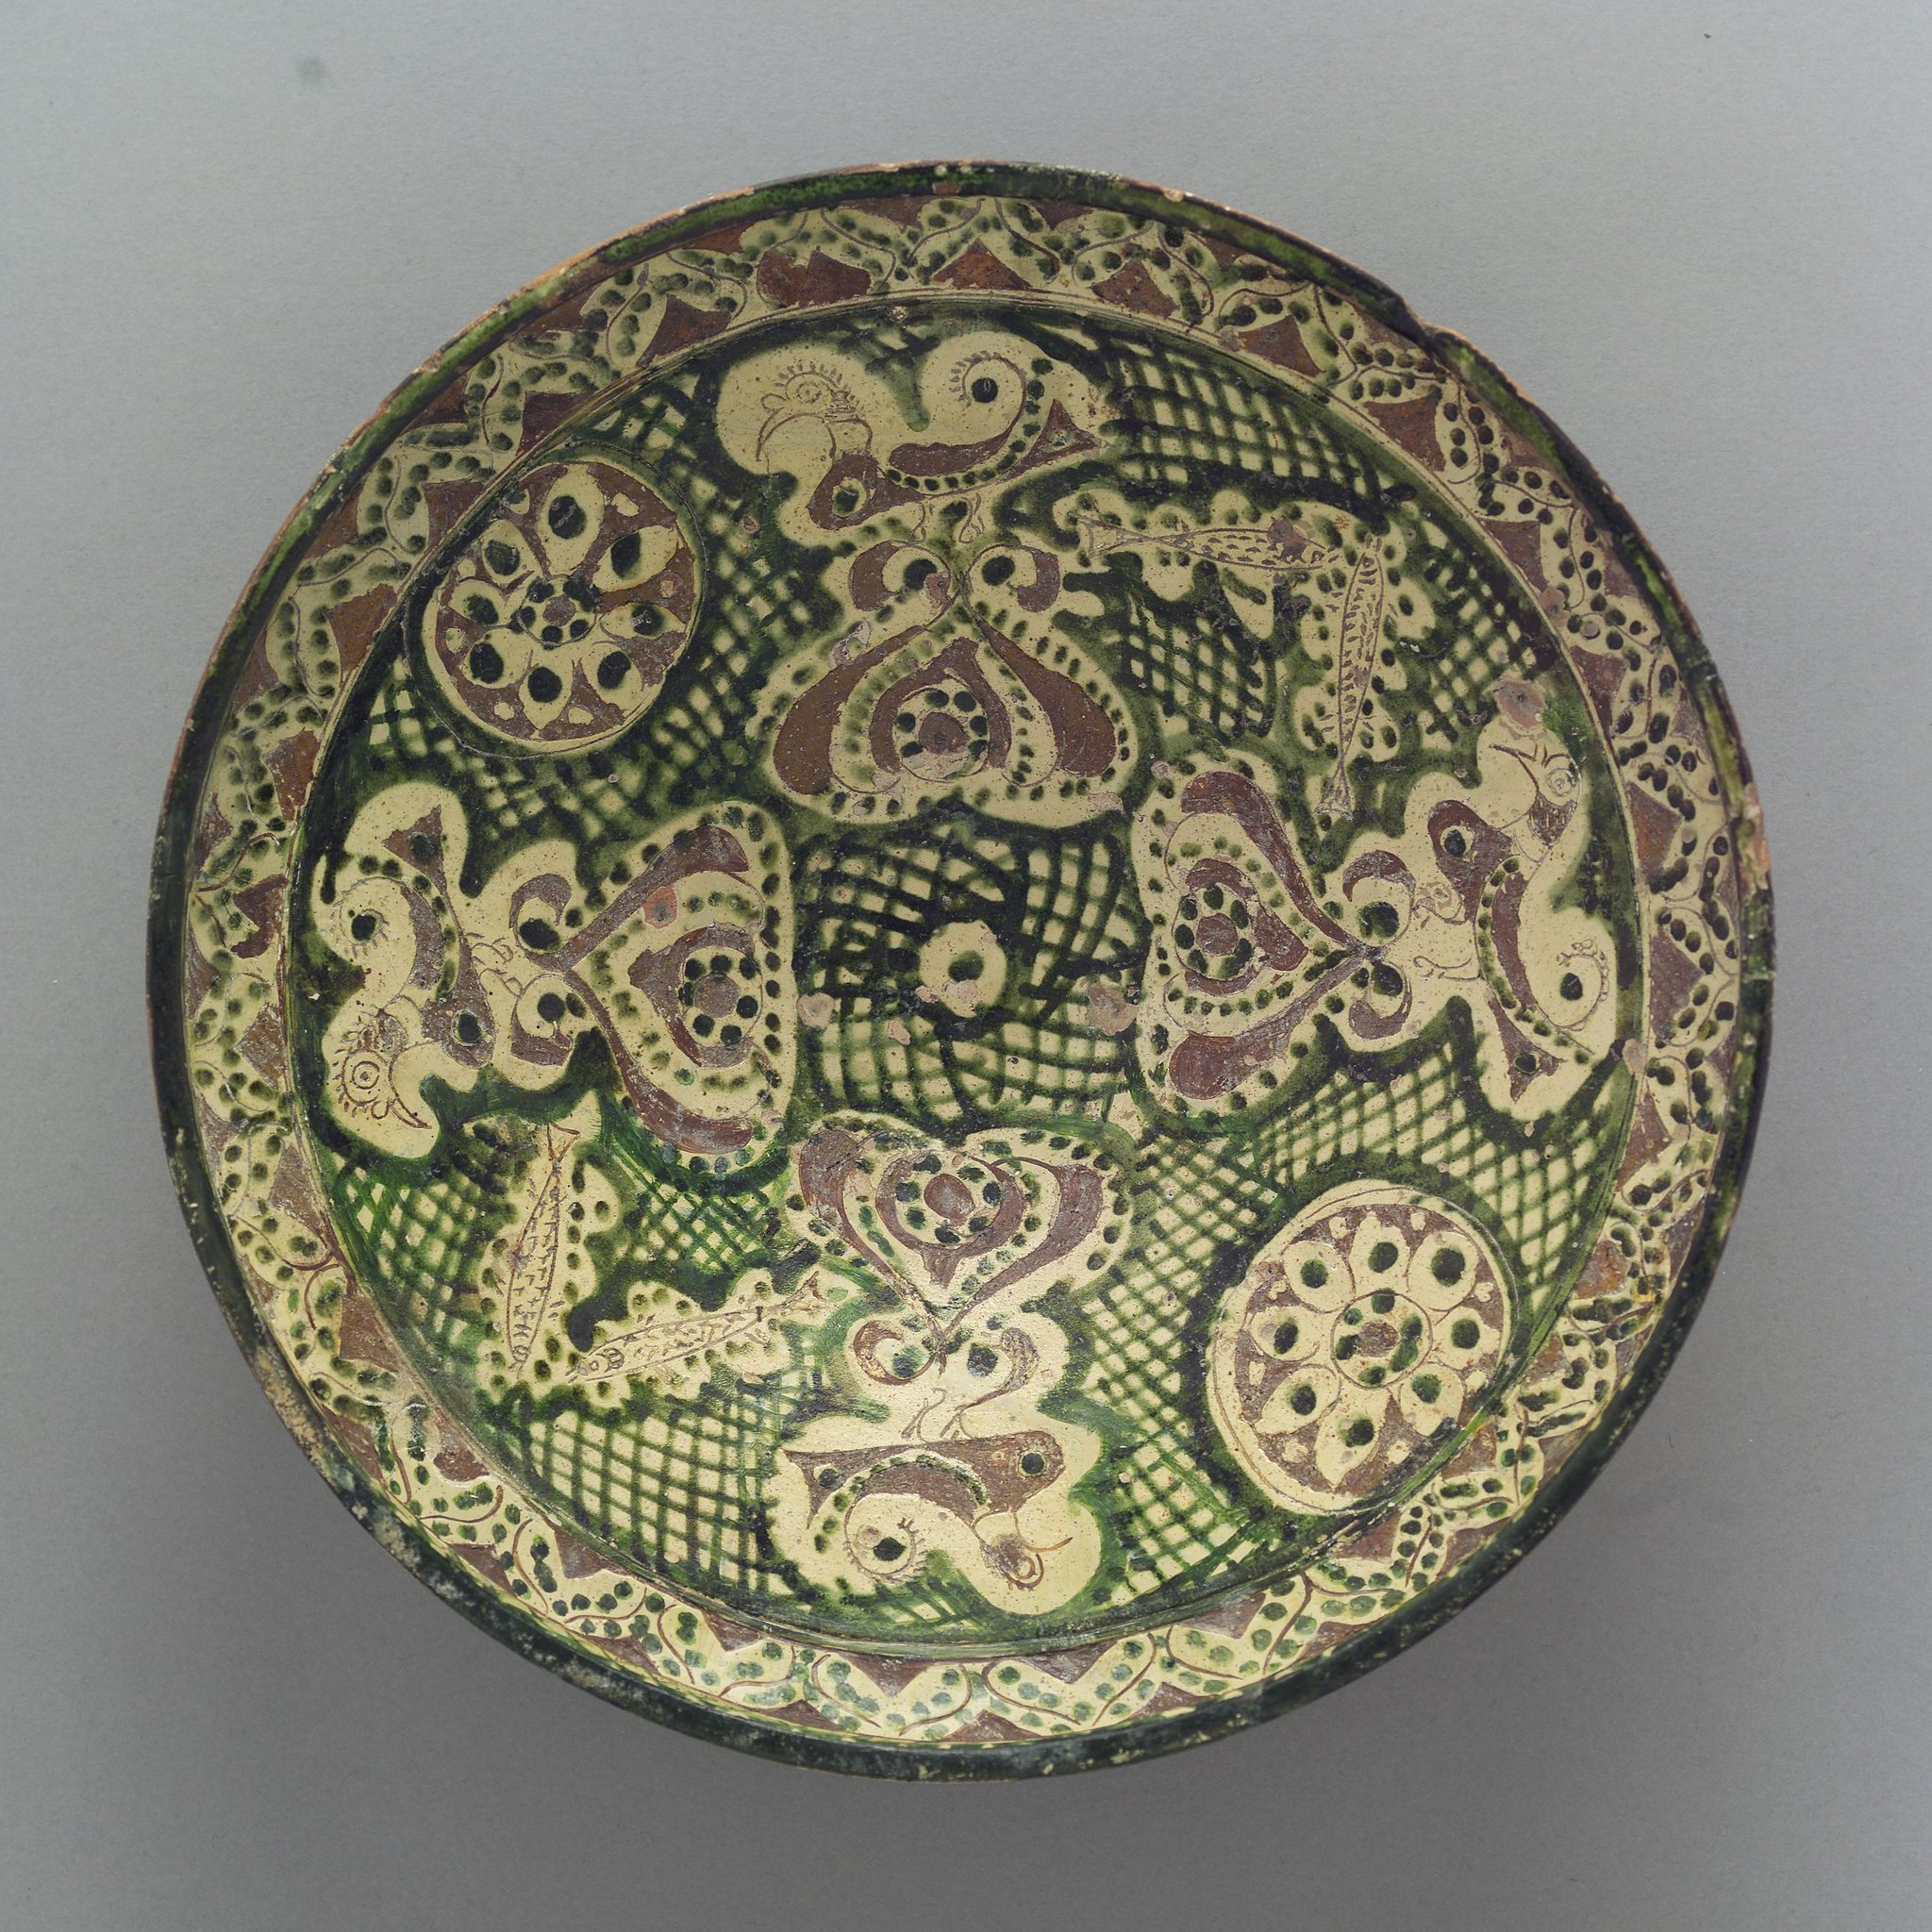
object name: bowl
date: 1201-1300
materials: earthenware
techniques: glazing, painting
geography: iran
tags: flowers